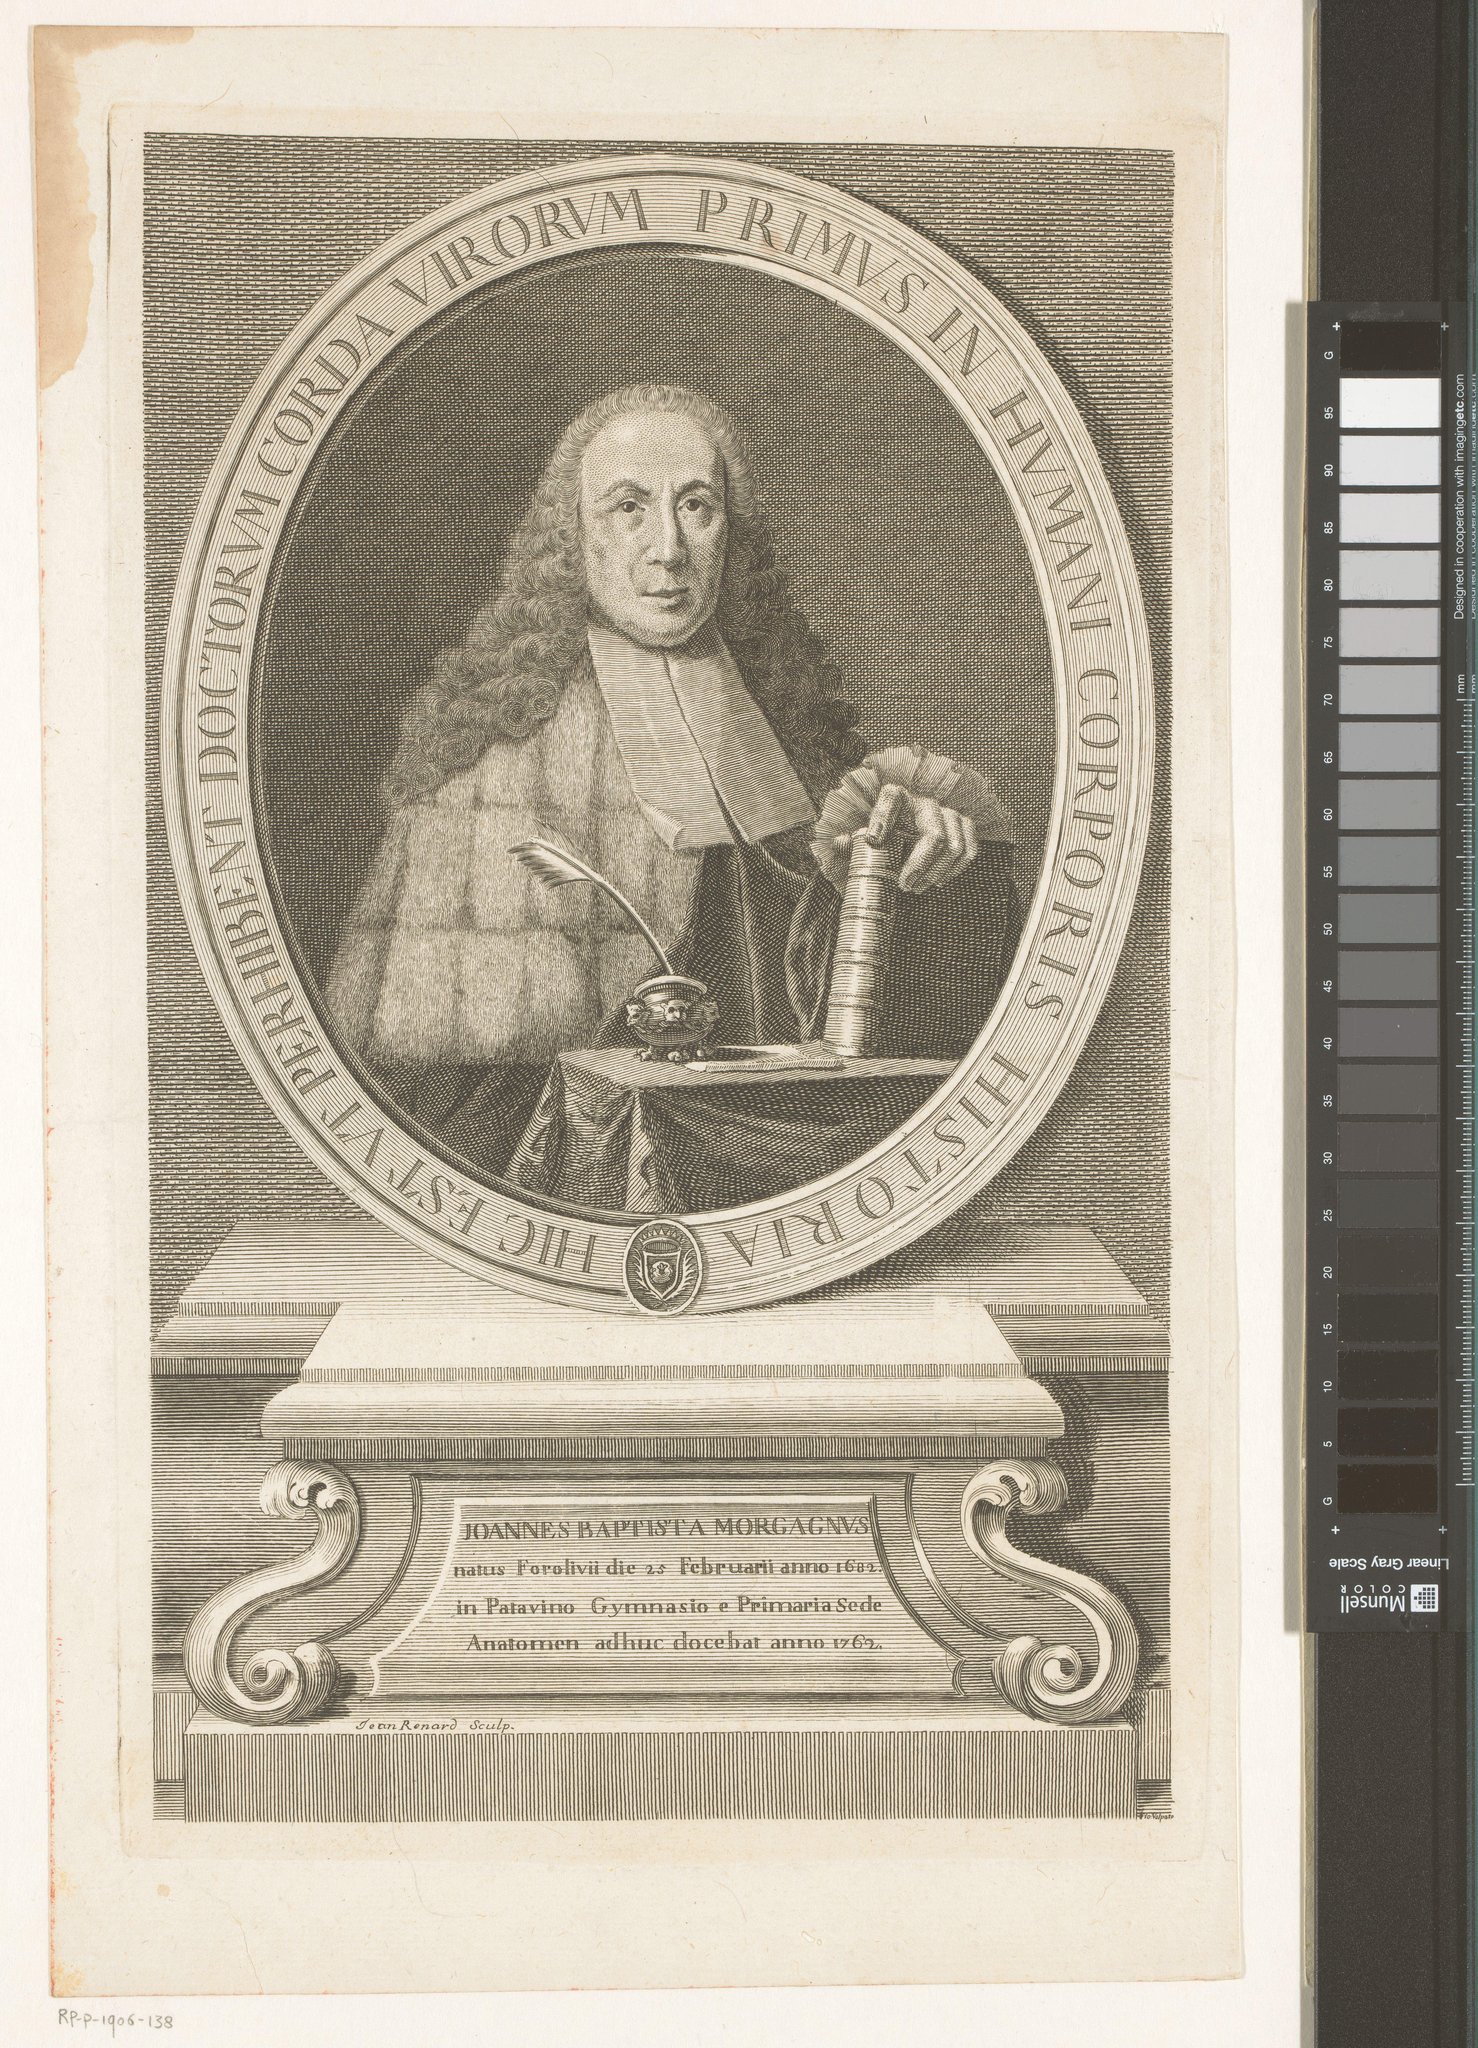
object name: print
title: Portret van anatoom Giovanni Battista Morgagni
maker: giovanni volpato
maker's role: ceramicist, print maker, printer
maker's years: 1735-1803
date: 1750-1803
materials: paper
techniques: engraving, etching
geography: italy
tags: historical persons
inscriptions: collector's mark: Lugt 2228